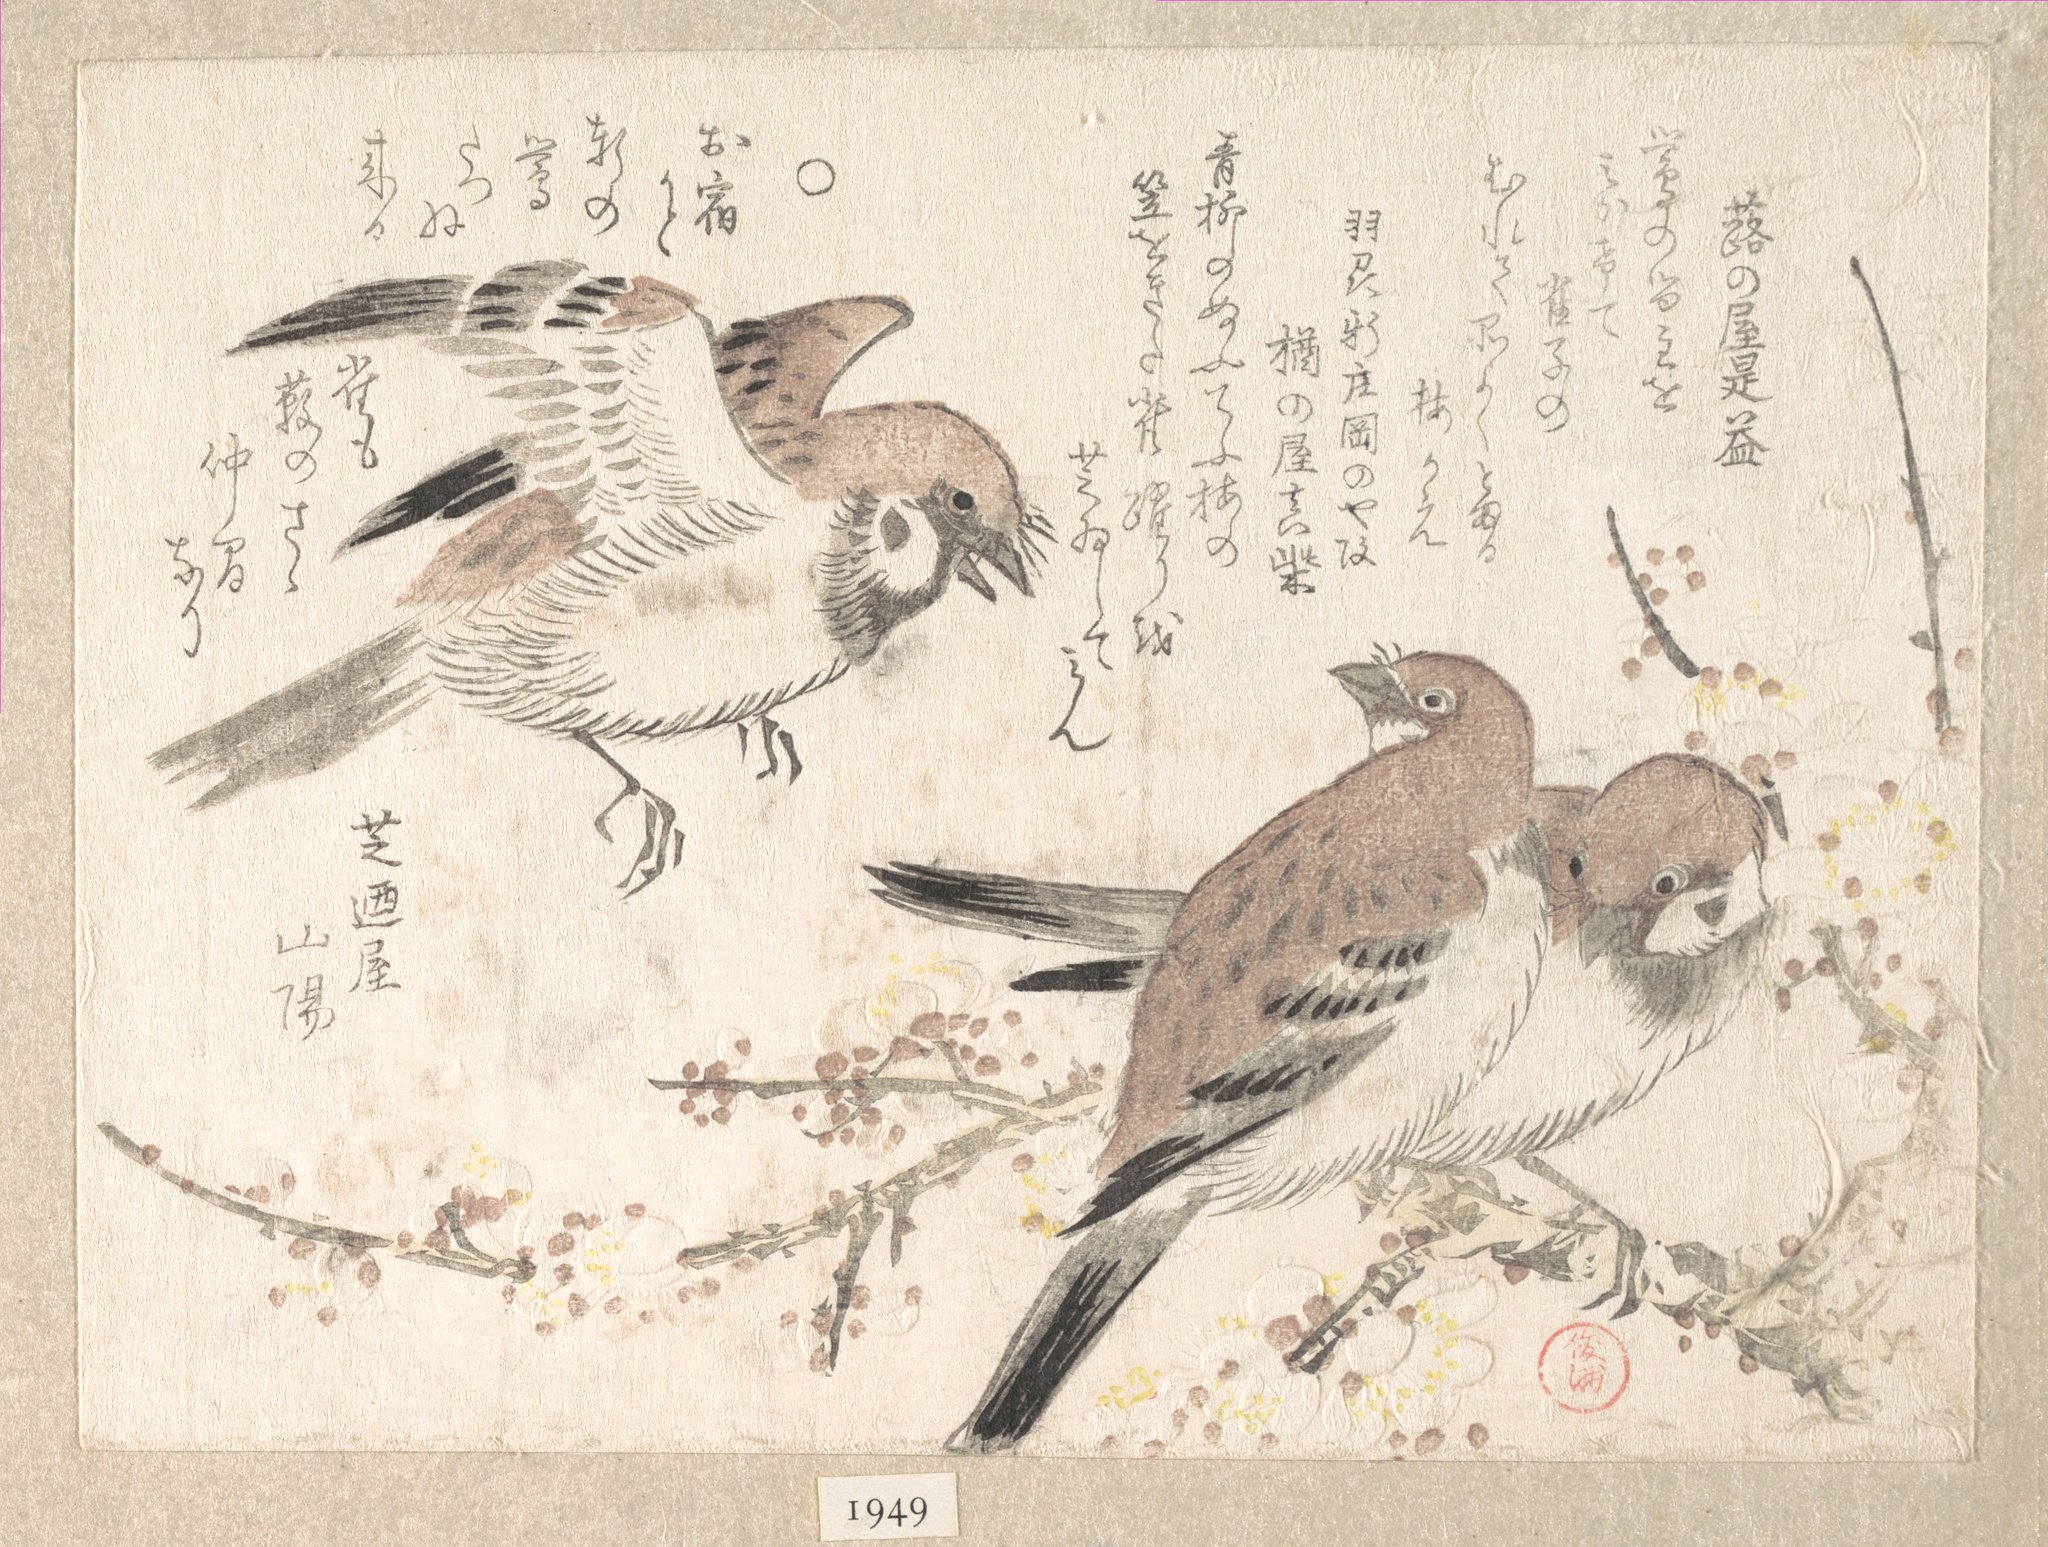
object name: print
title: Sparrows and Plum Blossoms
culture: japanese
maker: kubo shunman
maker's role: artist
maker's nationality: japanese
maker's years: 1757-1820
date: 1801-1900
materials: ink, paper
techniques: surimono, woodblock print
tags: birds